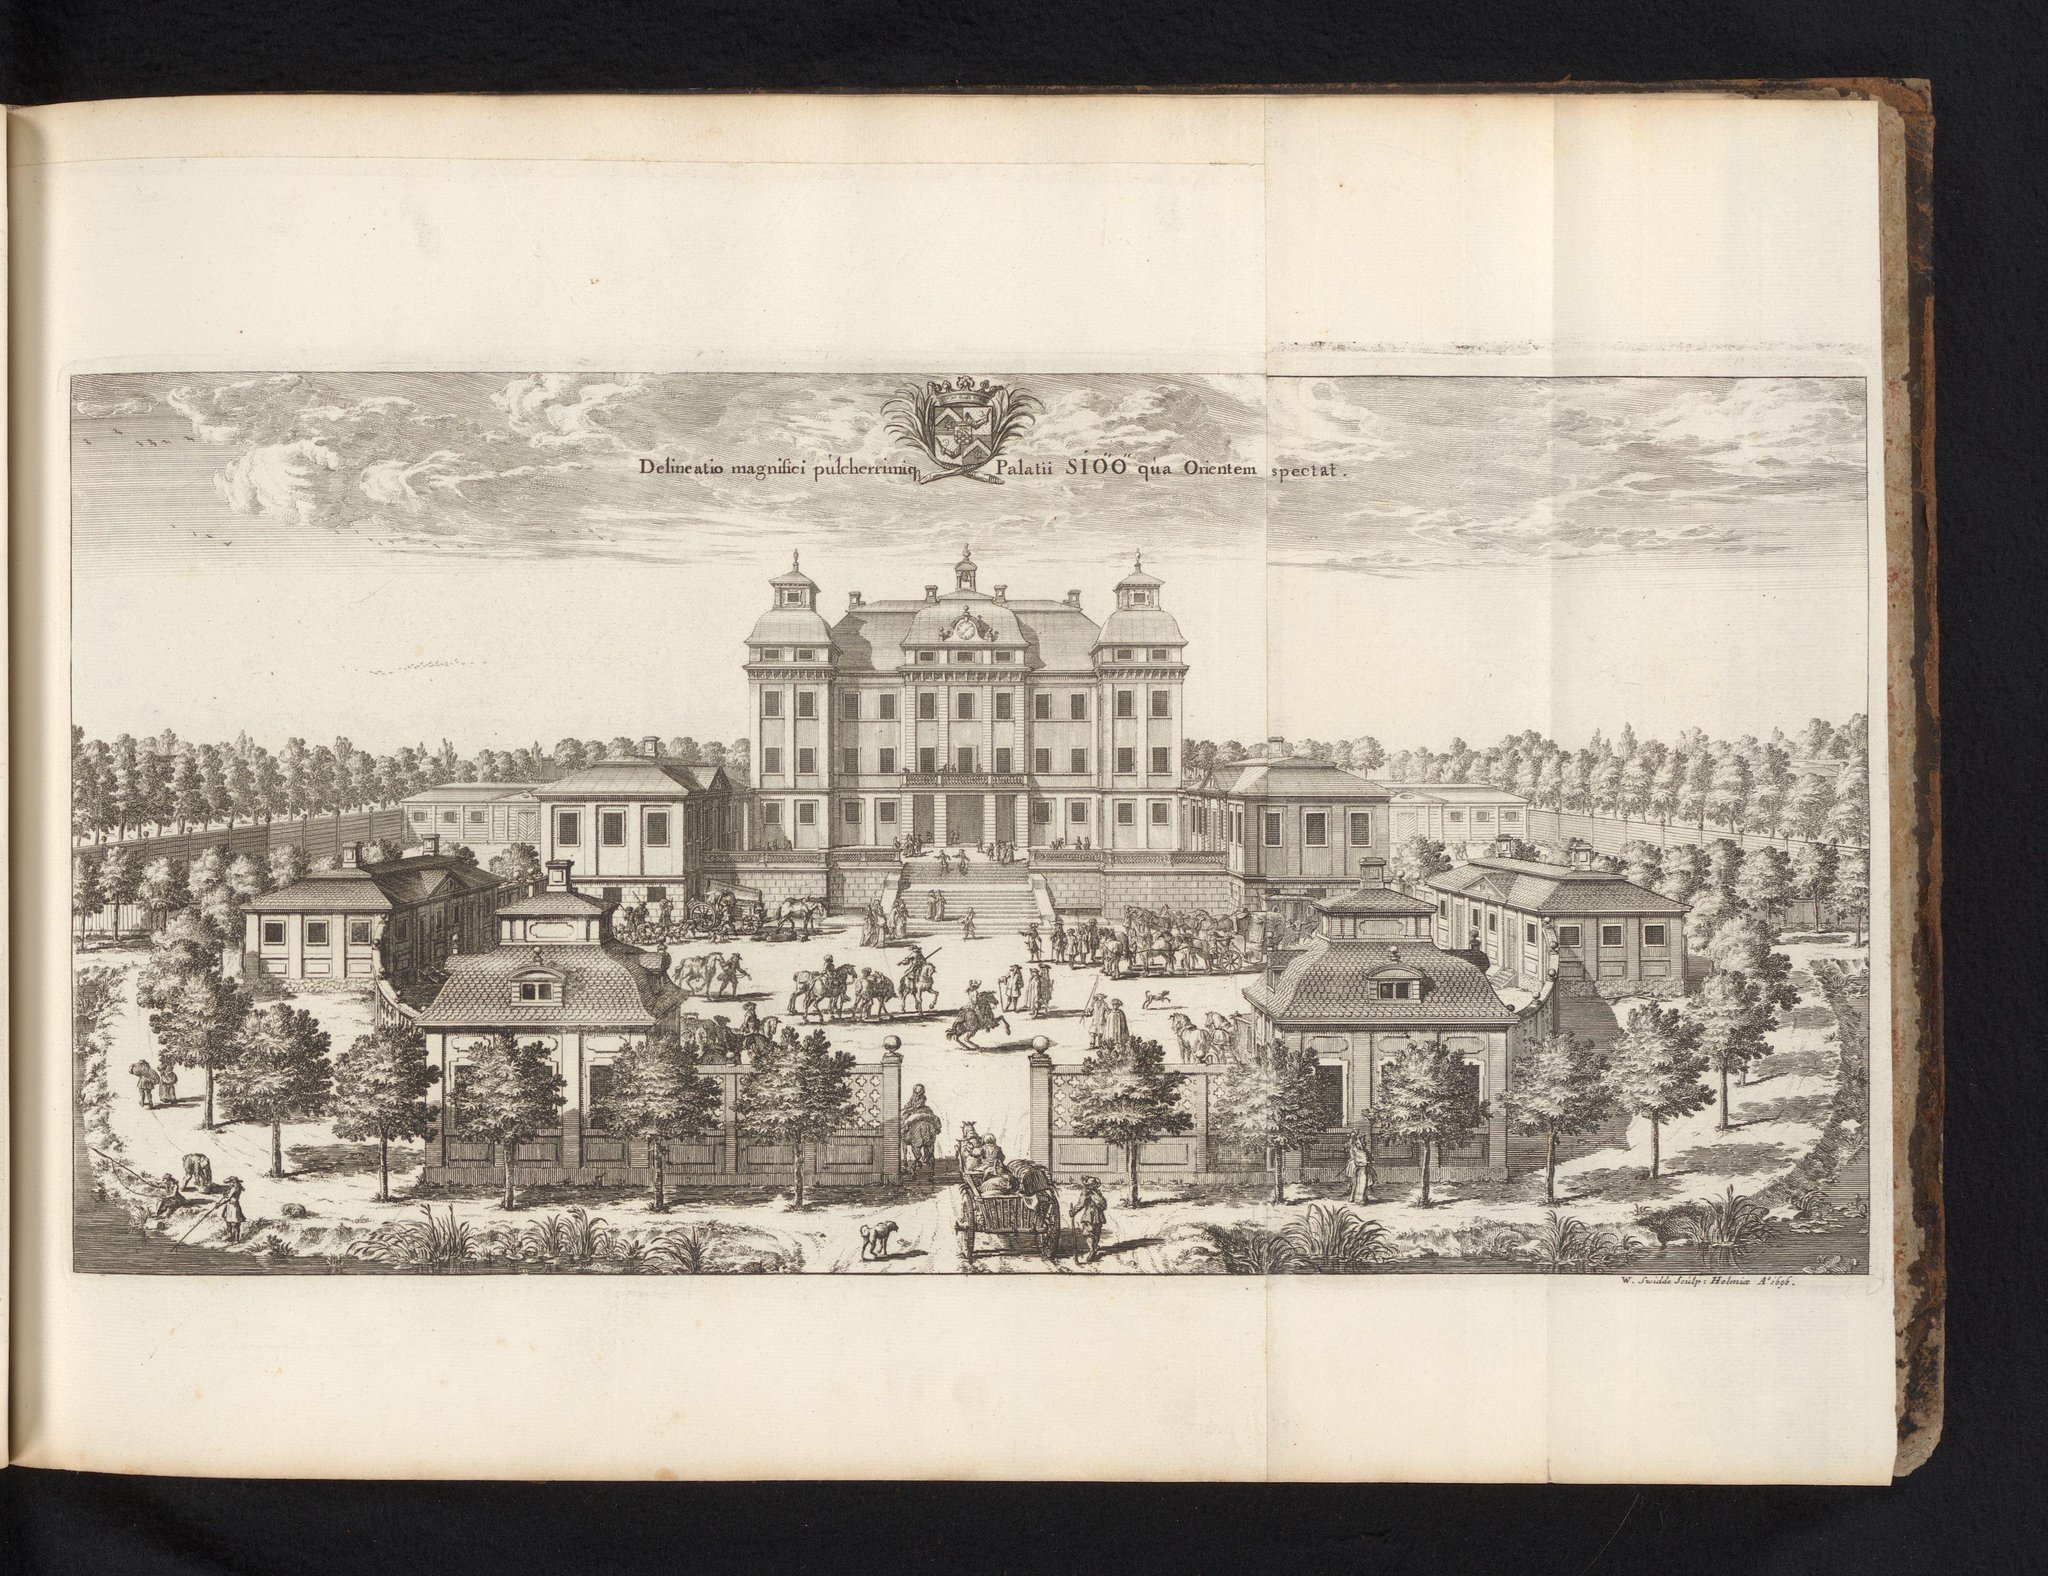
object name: print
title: Gezicht op slot Sjöö, vanuit het oosten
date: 1696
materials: paper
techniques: etching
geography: stockholm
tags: housing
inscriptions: date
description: Kungliga Biblioteket, 'Suecia': http://www.kb.se/samlingarna/Kartor-bilder/Suecia-antiqua/ (geraadpleegd november 2016).